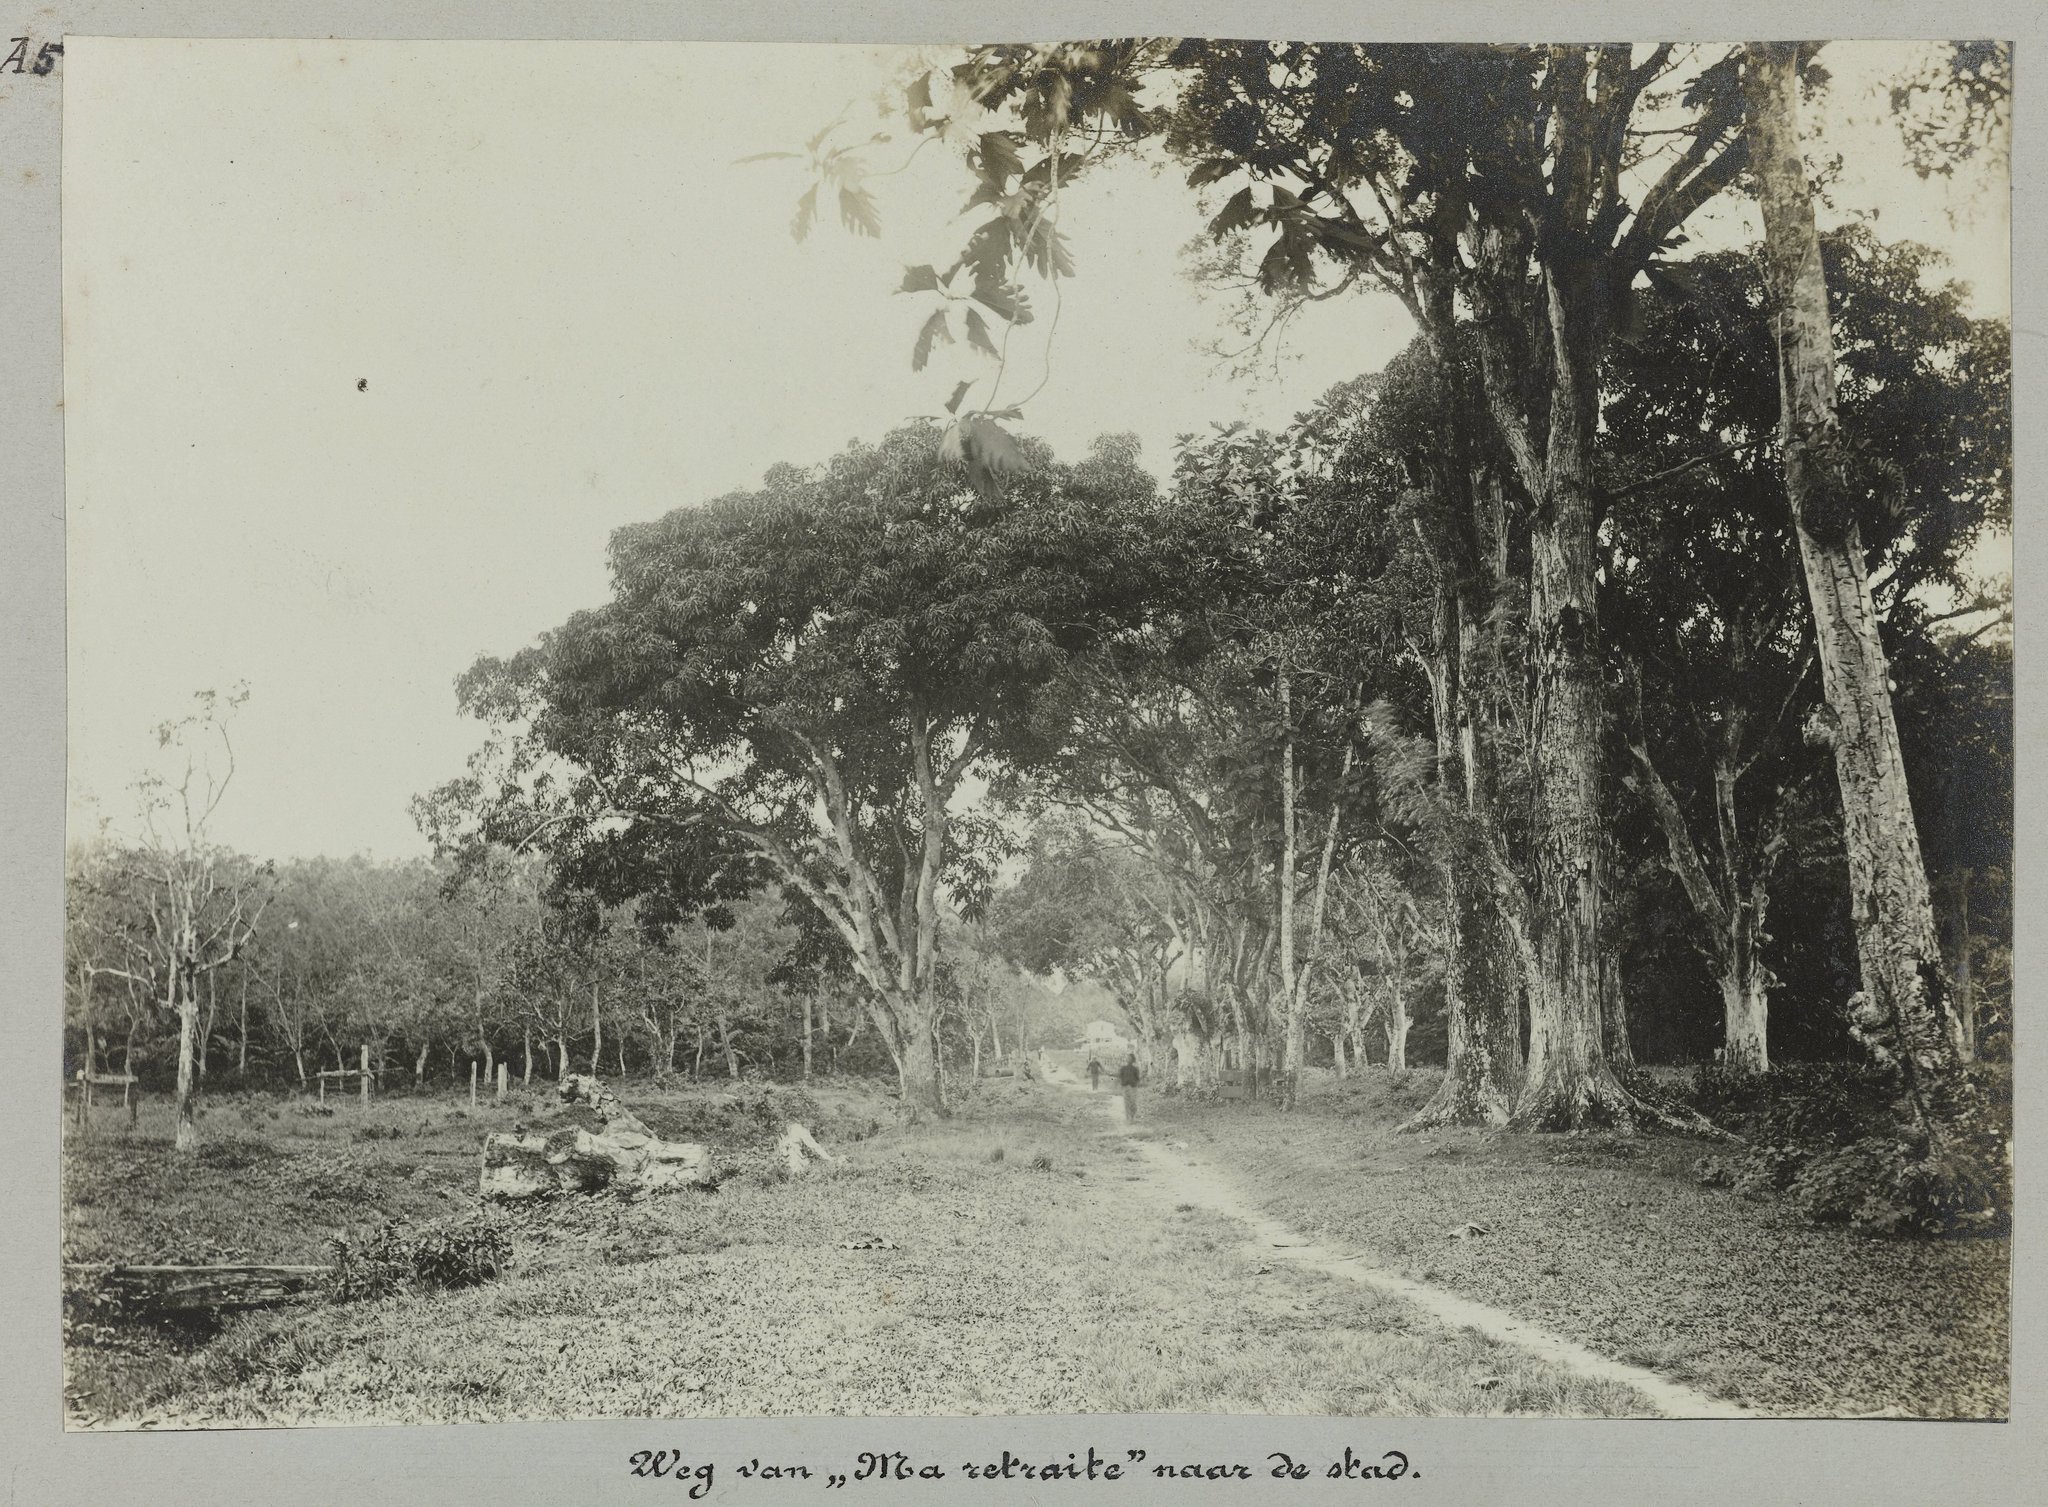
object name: photograph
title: Weg van "Ma retraite" naar de stad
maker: hendrik doijer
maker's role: engineer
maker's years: 1863-1925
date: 1903-1910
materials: photographic support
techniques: gelatin silver print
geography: suriname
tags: suriname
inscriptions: inscription: ‘A5 / Weg van "Ma retraite" naar de stad.’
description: De weg van de plantage Ma Retraite naar Paramaribo. Onderdeel van het fotoalbum Souvenir de Voyage (deel 1), over het leven van de familie Doijer in en rond de plantage Ma Retraite in Suriname in de jaren 1903-1910.